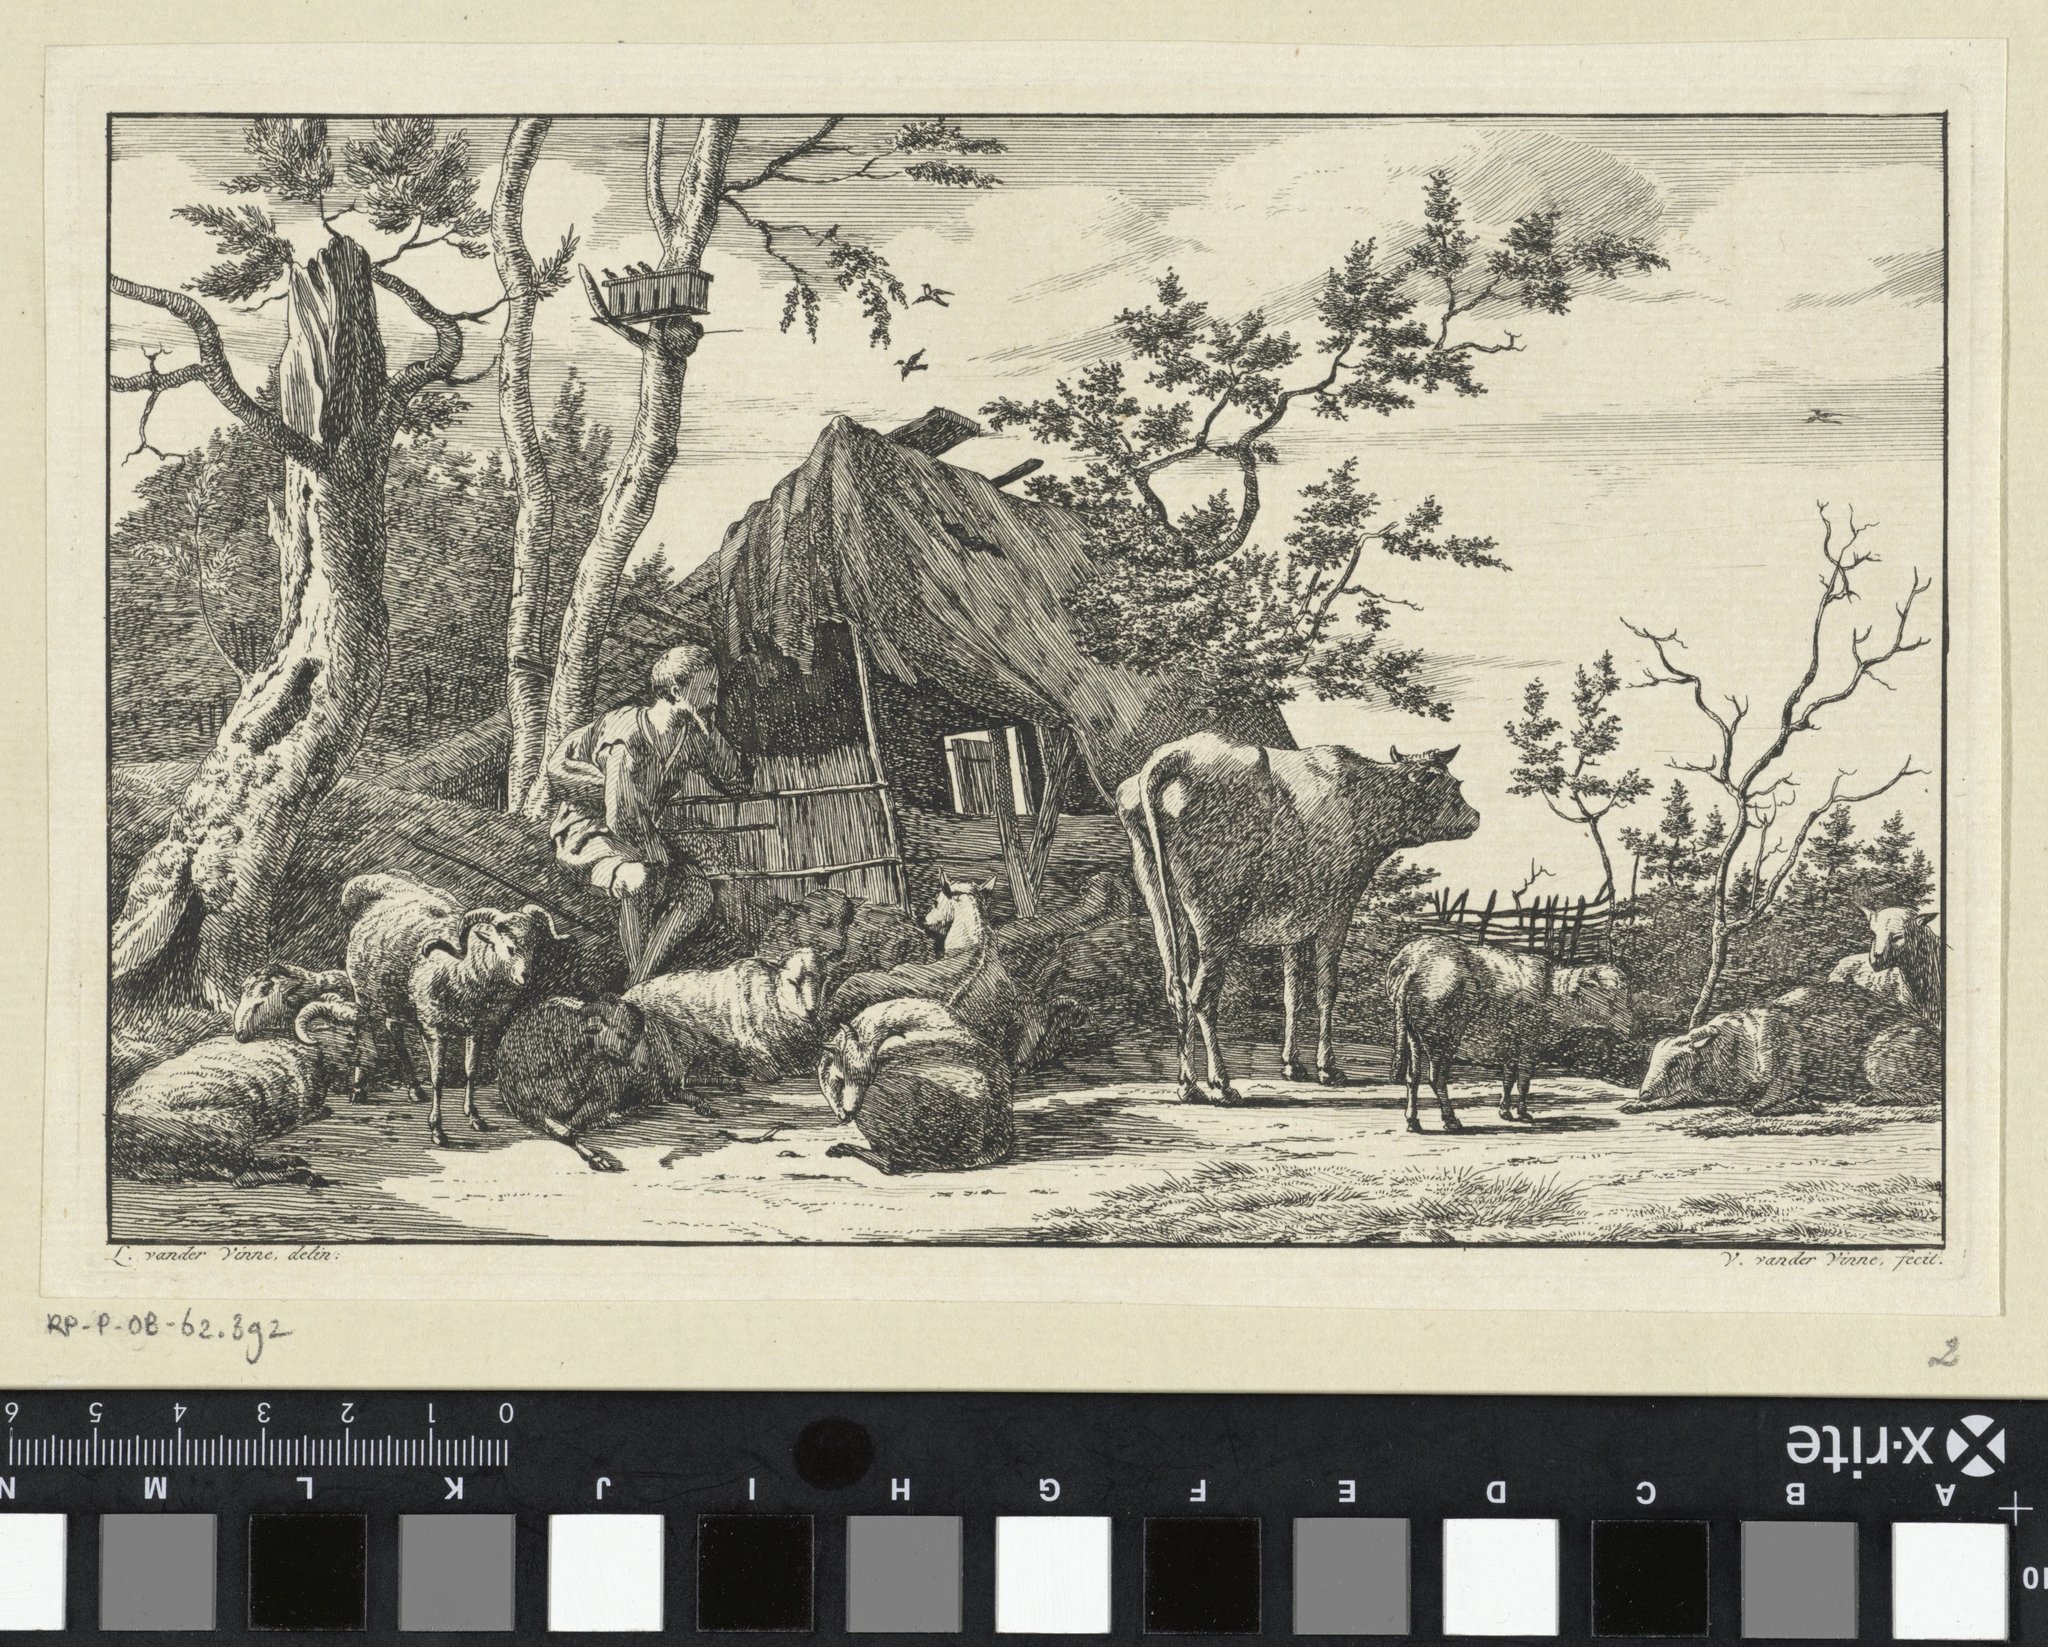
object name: print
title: Zittende herder met vee voor een vervallen schuur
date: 1746-1811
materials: paper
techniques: etching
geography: haarlem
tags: nesting-box, barn, herding, herdsman, herdswoman, shepherd, shepherdess, cowherd, etc., herd, flock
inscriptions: collector's mark: Lugt 2228